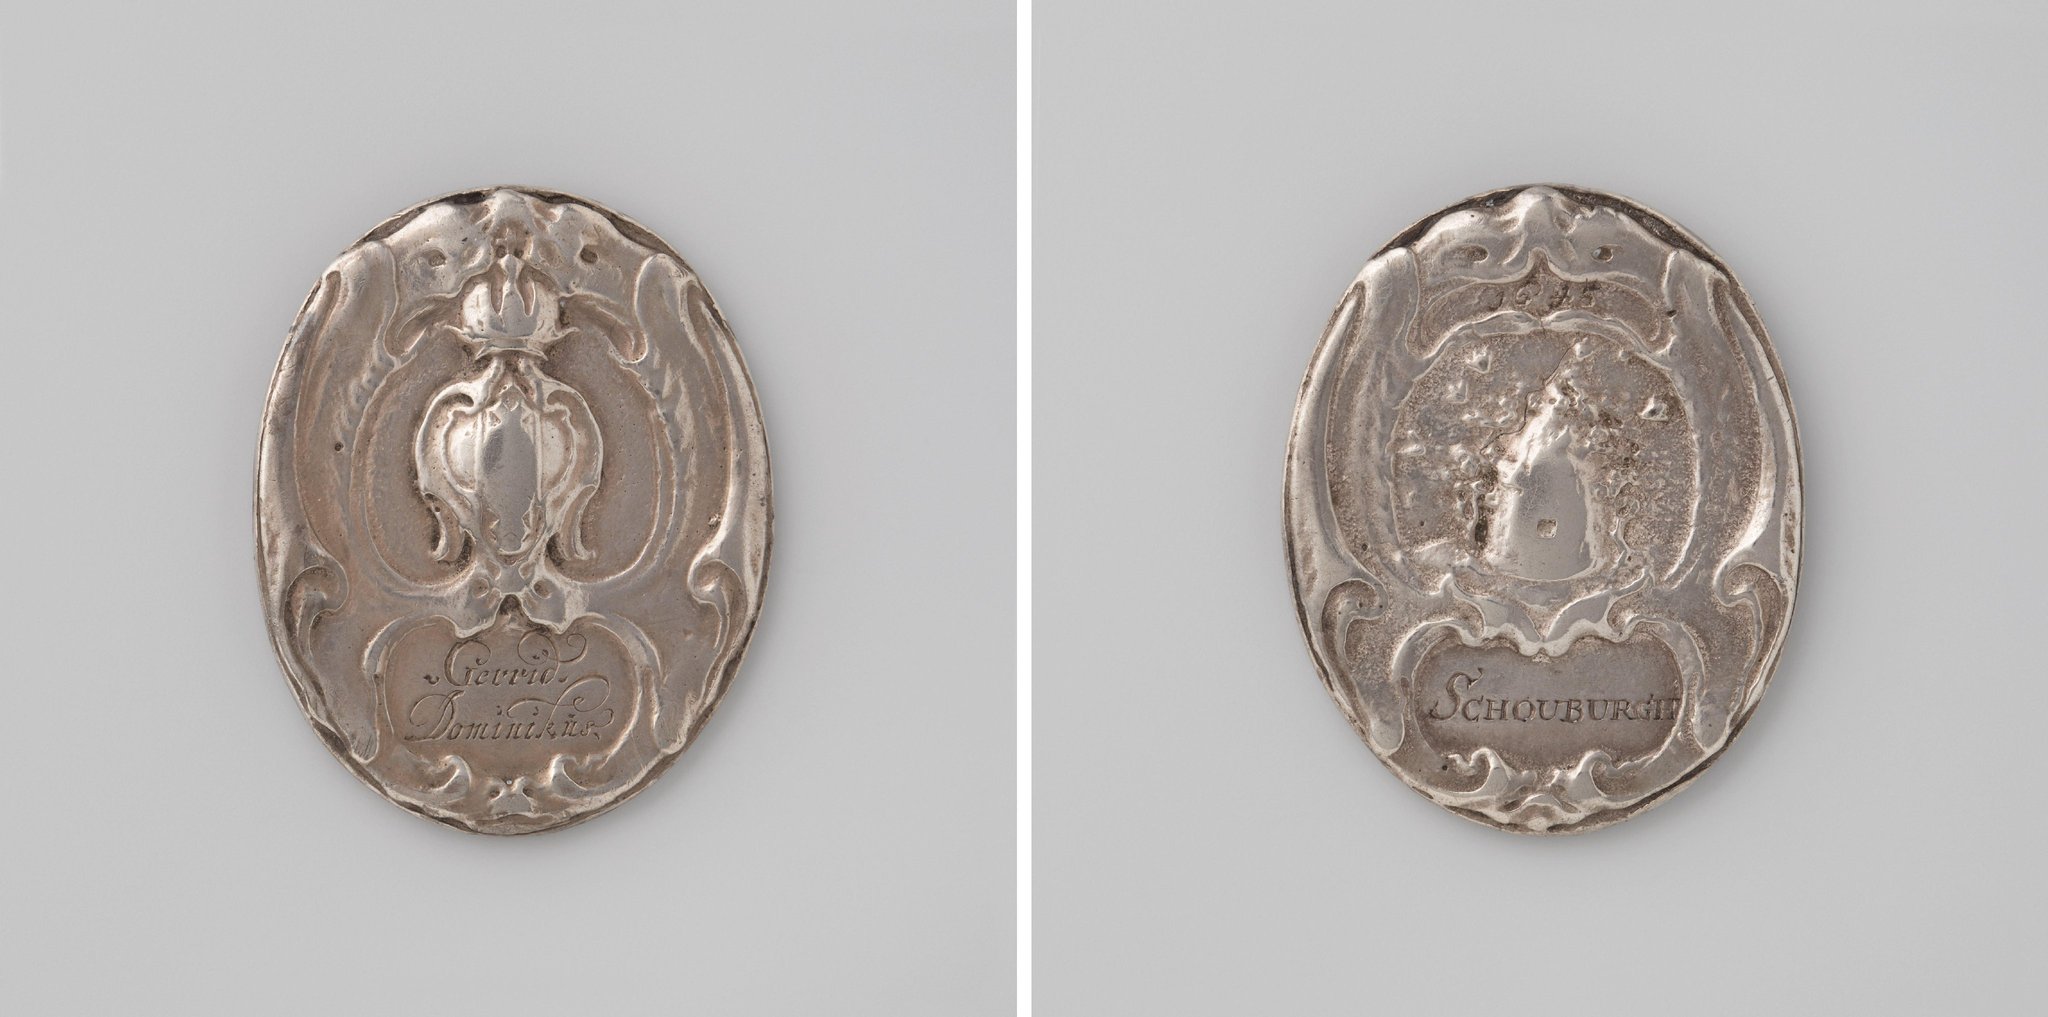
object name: medal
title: Toegangspenning schouwburg te Amsterdam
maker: johannes lutma (1624-1689)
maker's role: print maker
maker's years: 1624-1689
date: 1645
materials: silver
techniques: striking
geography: amsterdam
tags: amsterdam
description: Admission token for the Amsterdam theatre. Silver, Amsterdam, 1643, by Johannes Lutma.